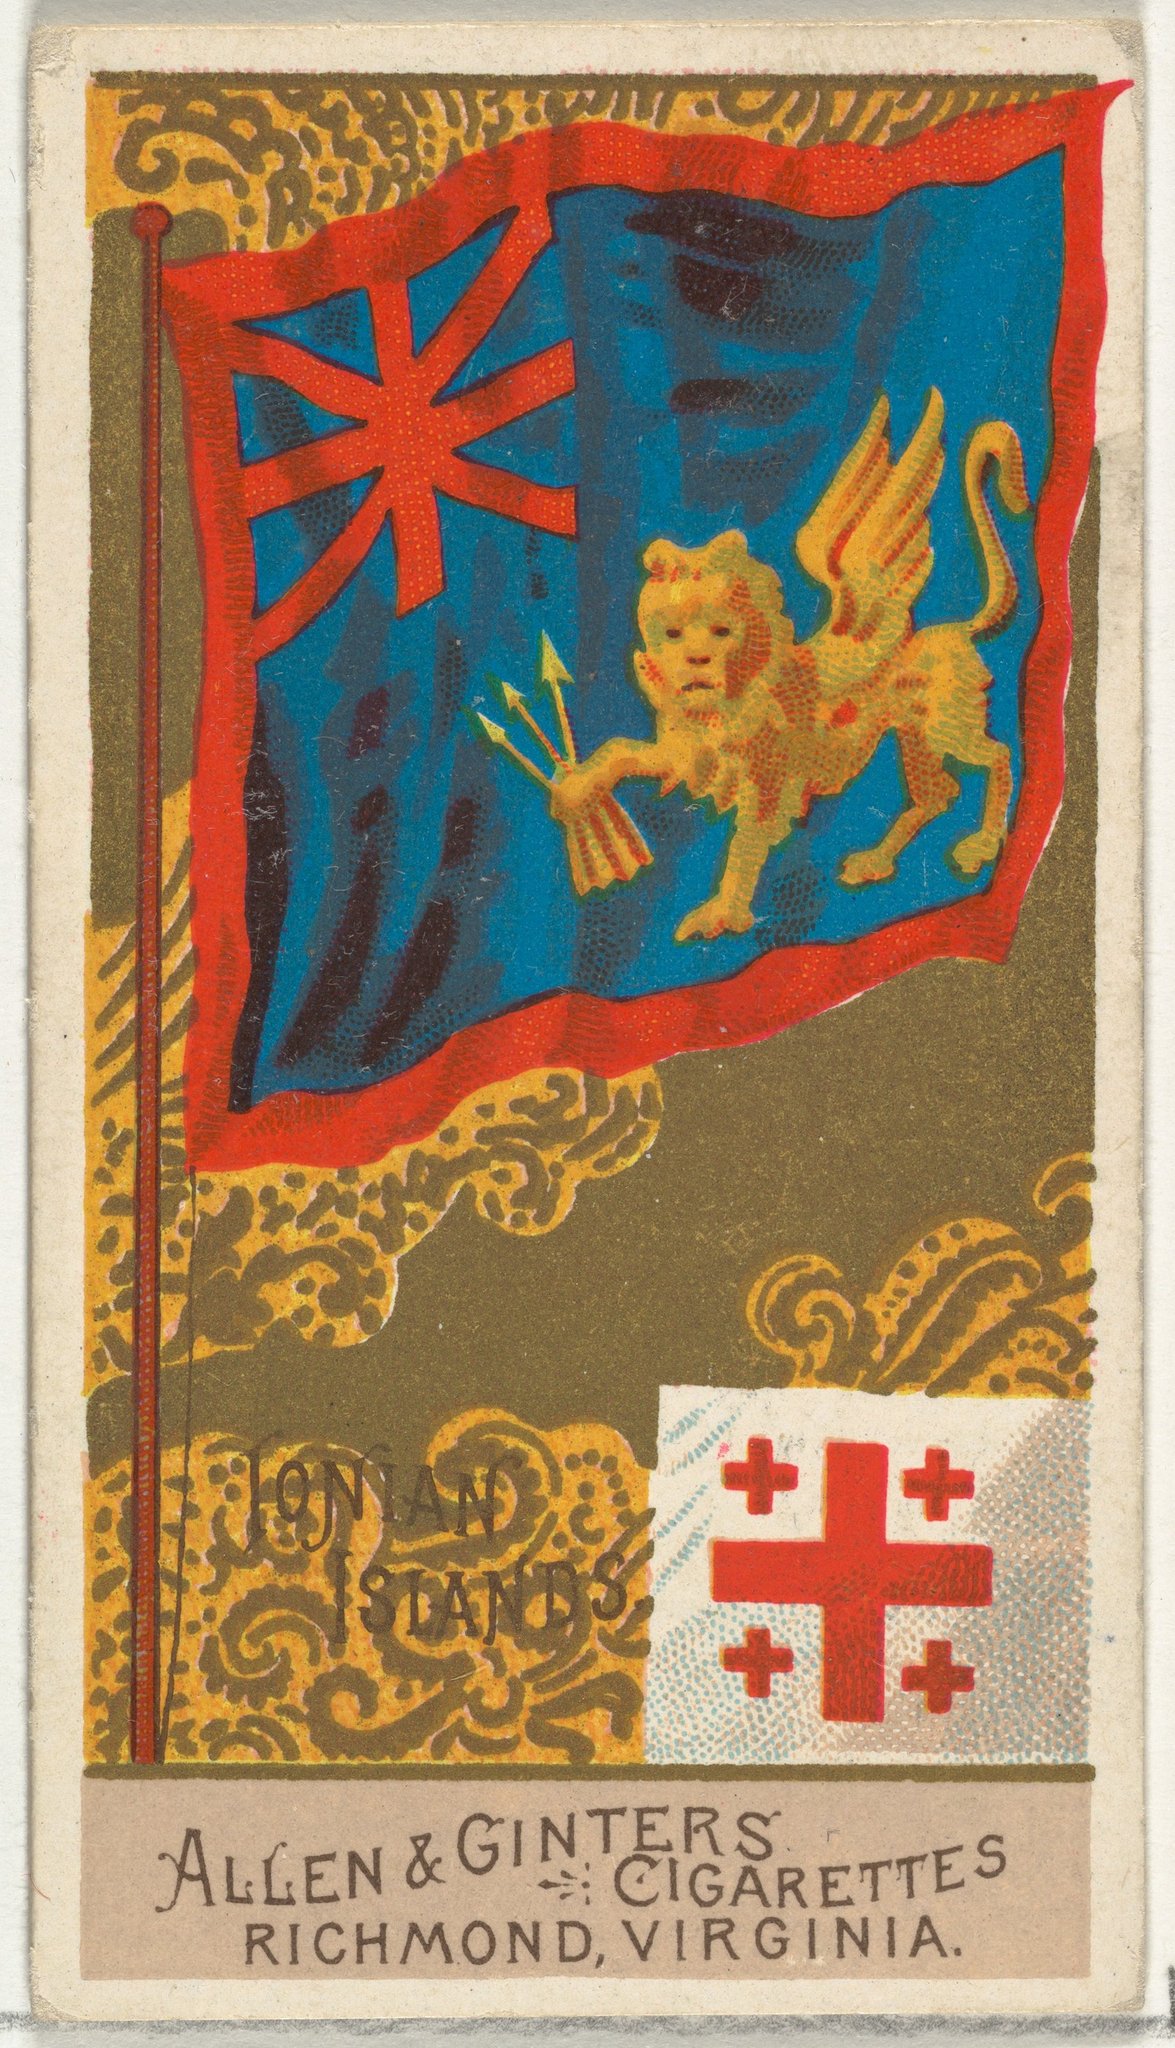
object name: print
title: Ionian Islands, from Flags of All Nations, Series 2 (N10) for Allen & Ginter Cigarettes Brands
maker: allen & ginter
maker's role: publisher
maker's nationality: american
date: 1890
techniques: color lithograph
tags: flags